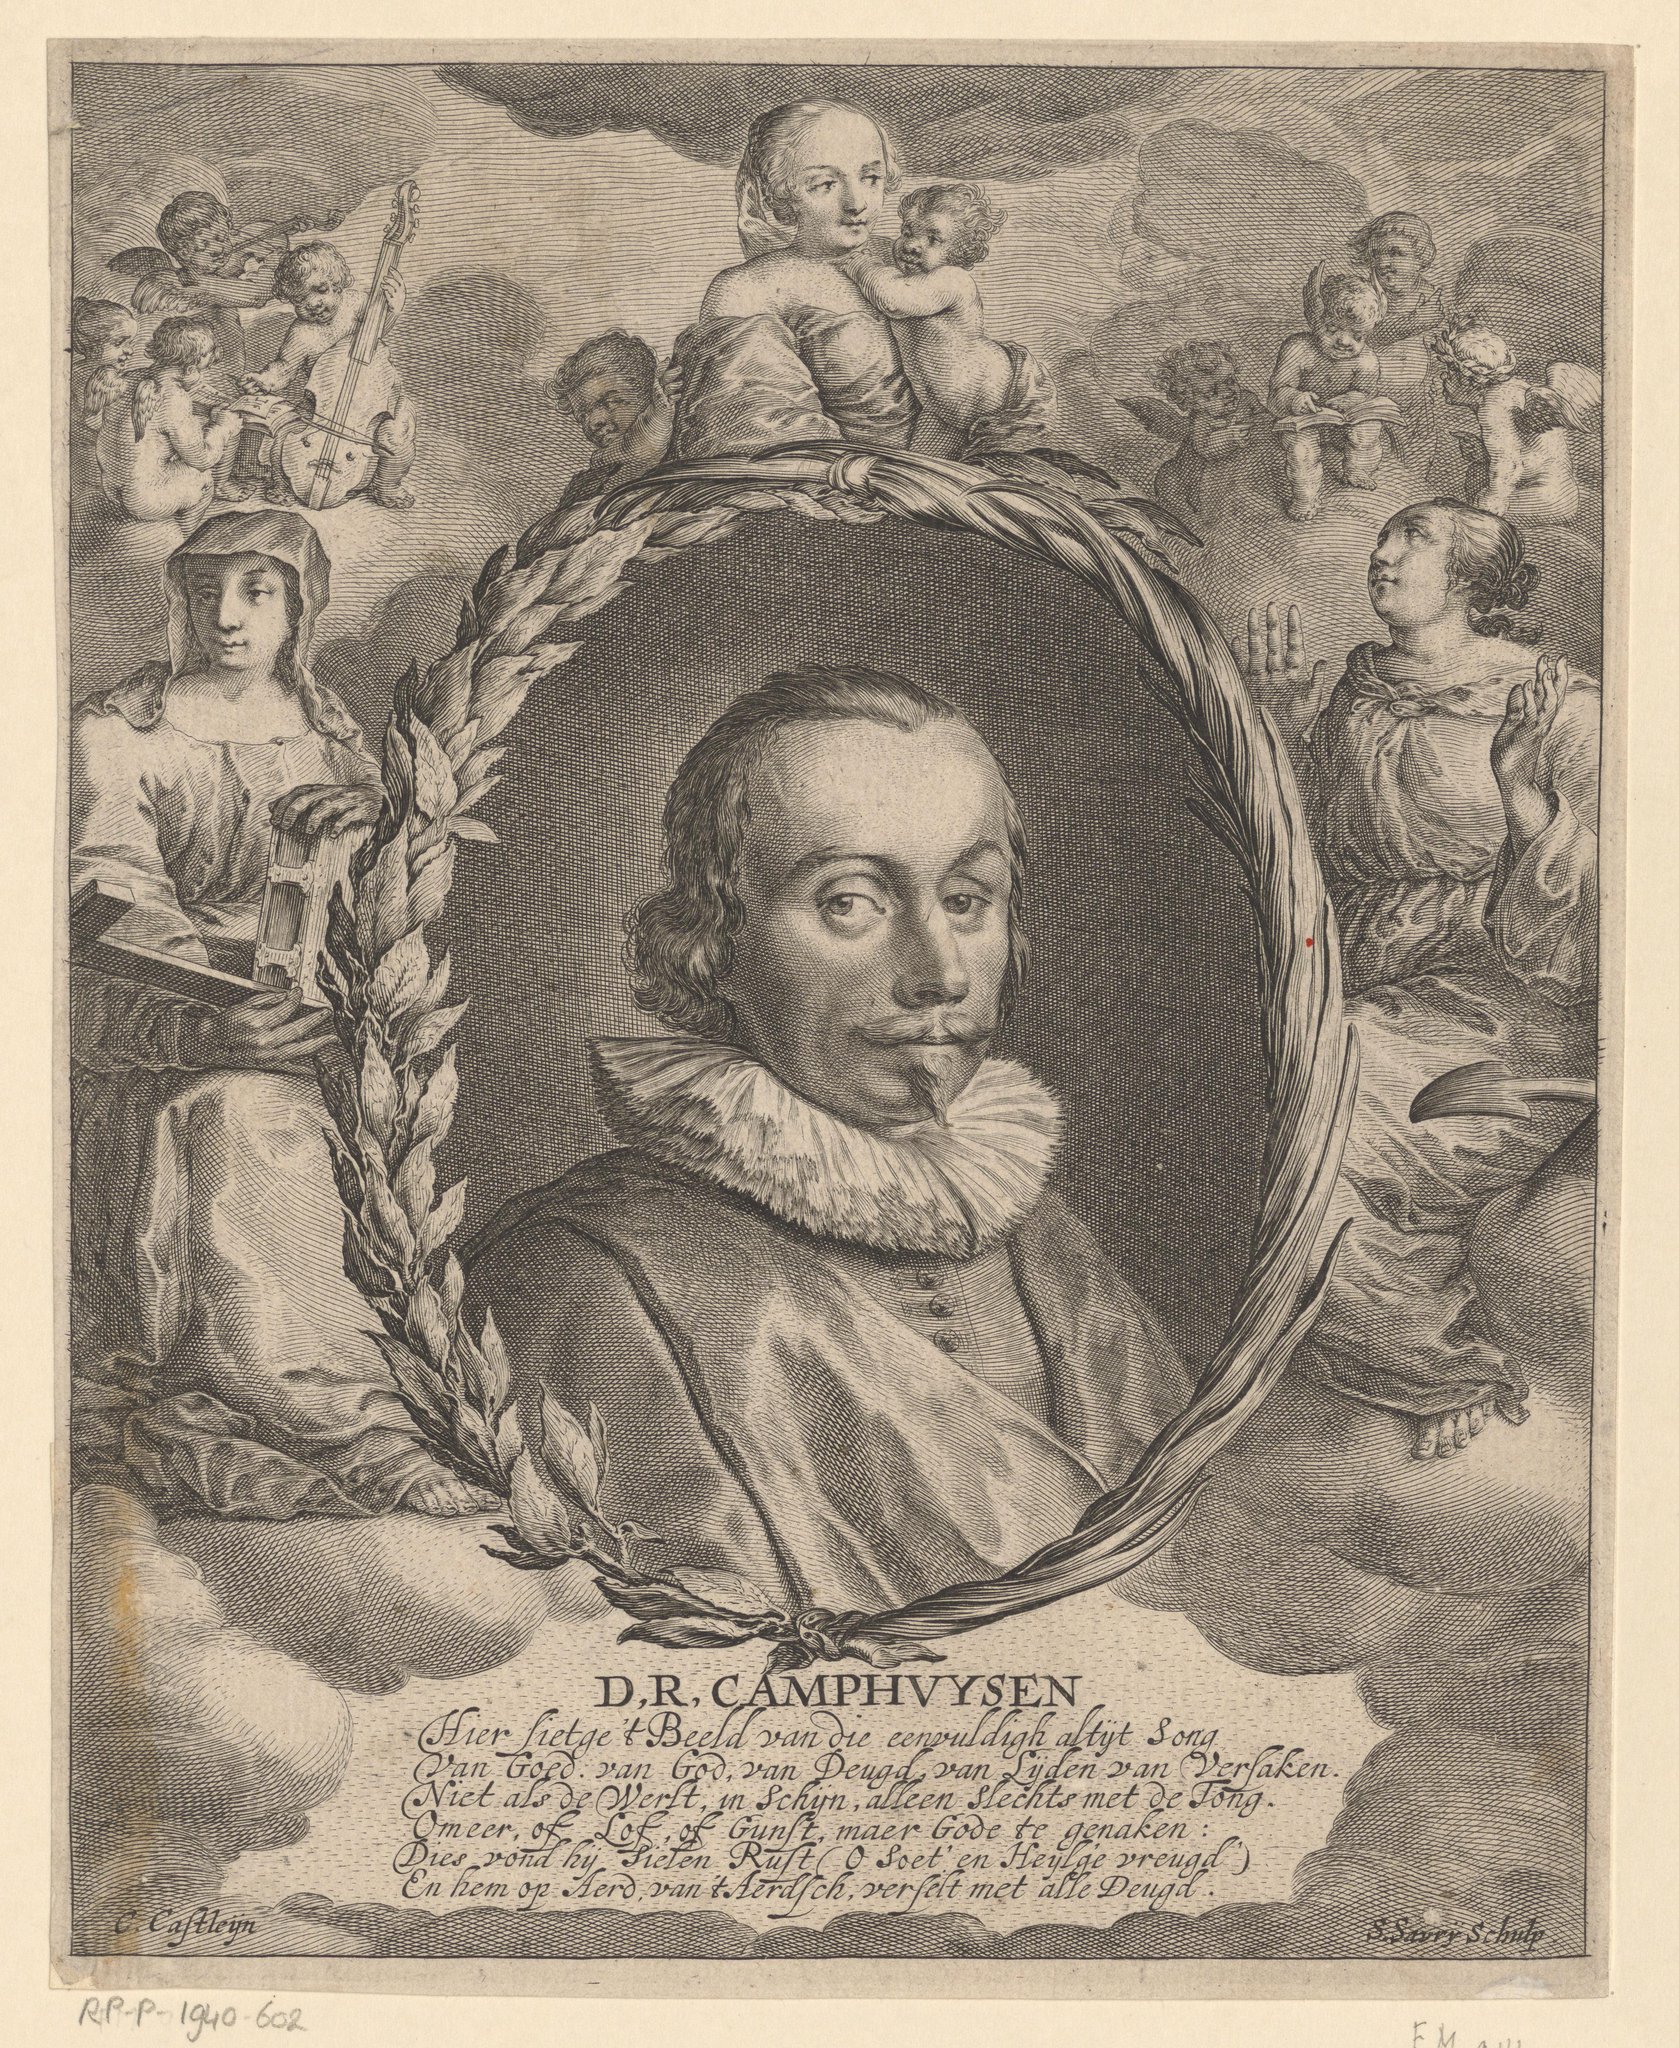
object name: print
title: Portret van Dirck Rafaelsz. Camphuysen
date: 1635-1683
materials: paper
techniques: engraving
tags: historical persons, portrait, self-portrait of painter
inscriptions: collector's mark: Lugt 2228, collector's mark: Lugt 2760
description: Om het portret zijn de personicaties Geloof, Hoop en Liefde uitgebeeld. Onder het portret een zesregelig vers.